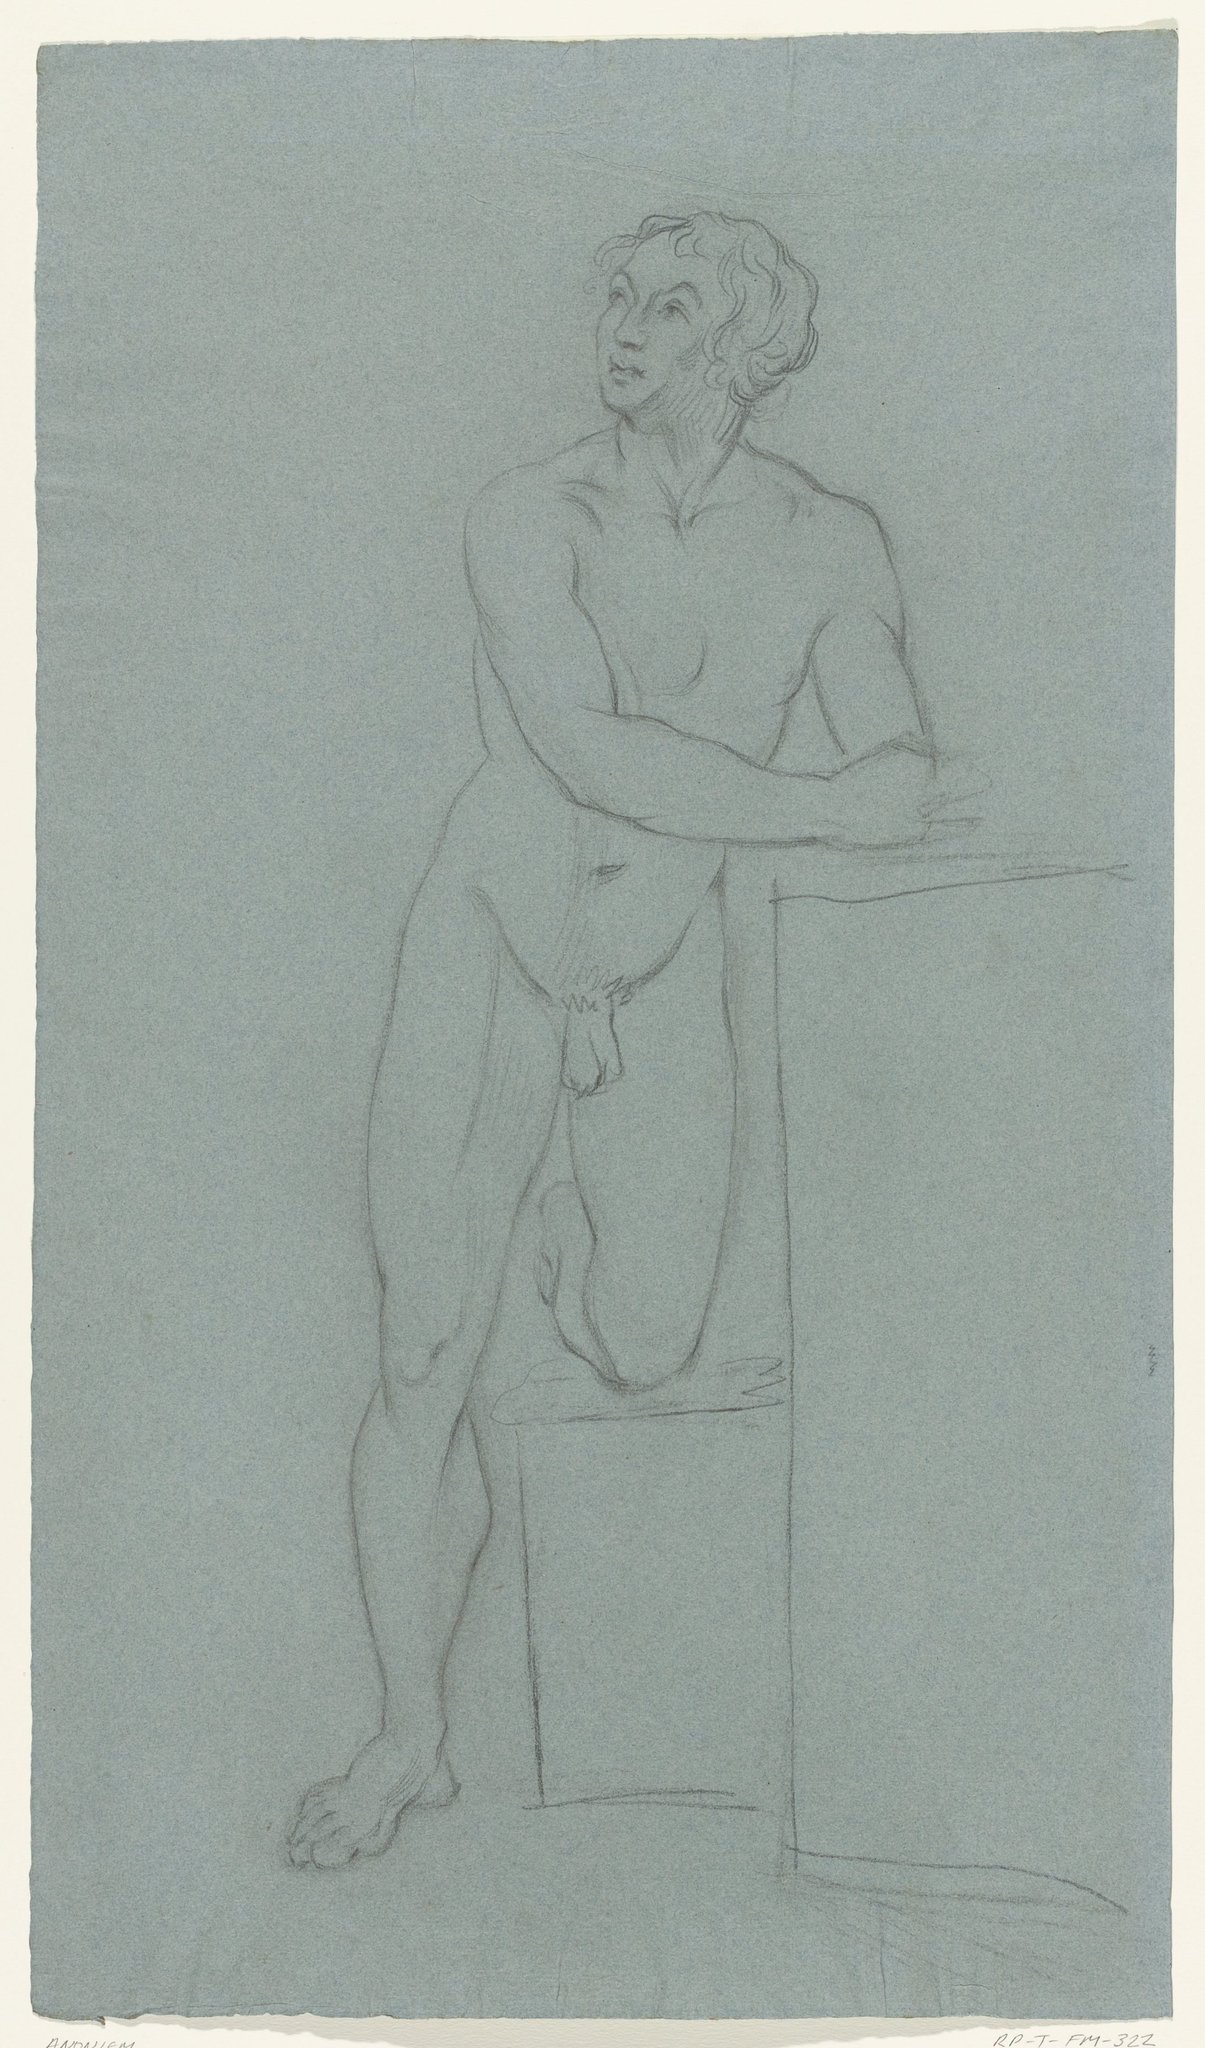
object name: drawing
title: Mannelijk naakt, met een been geknield op een blok en leunend op een andere blok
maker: Anonymous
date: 1802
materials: chalk, paper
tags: standing figure